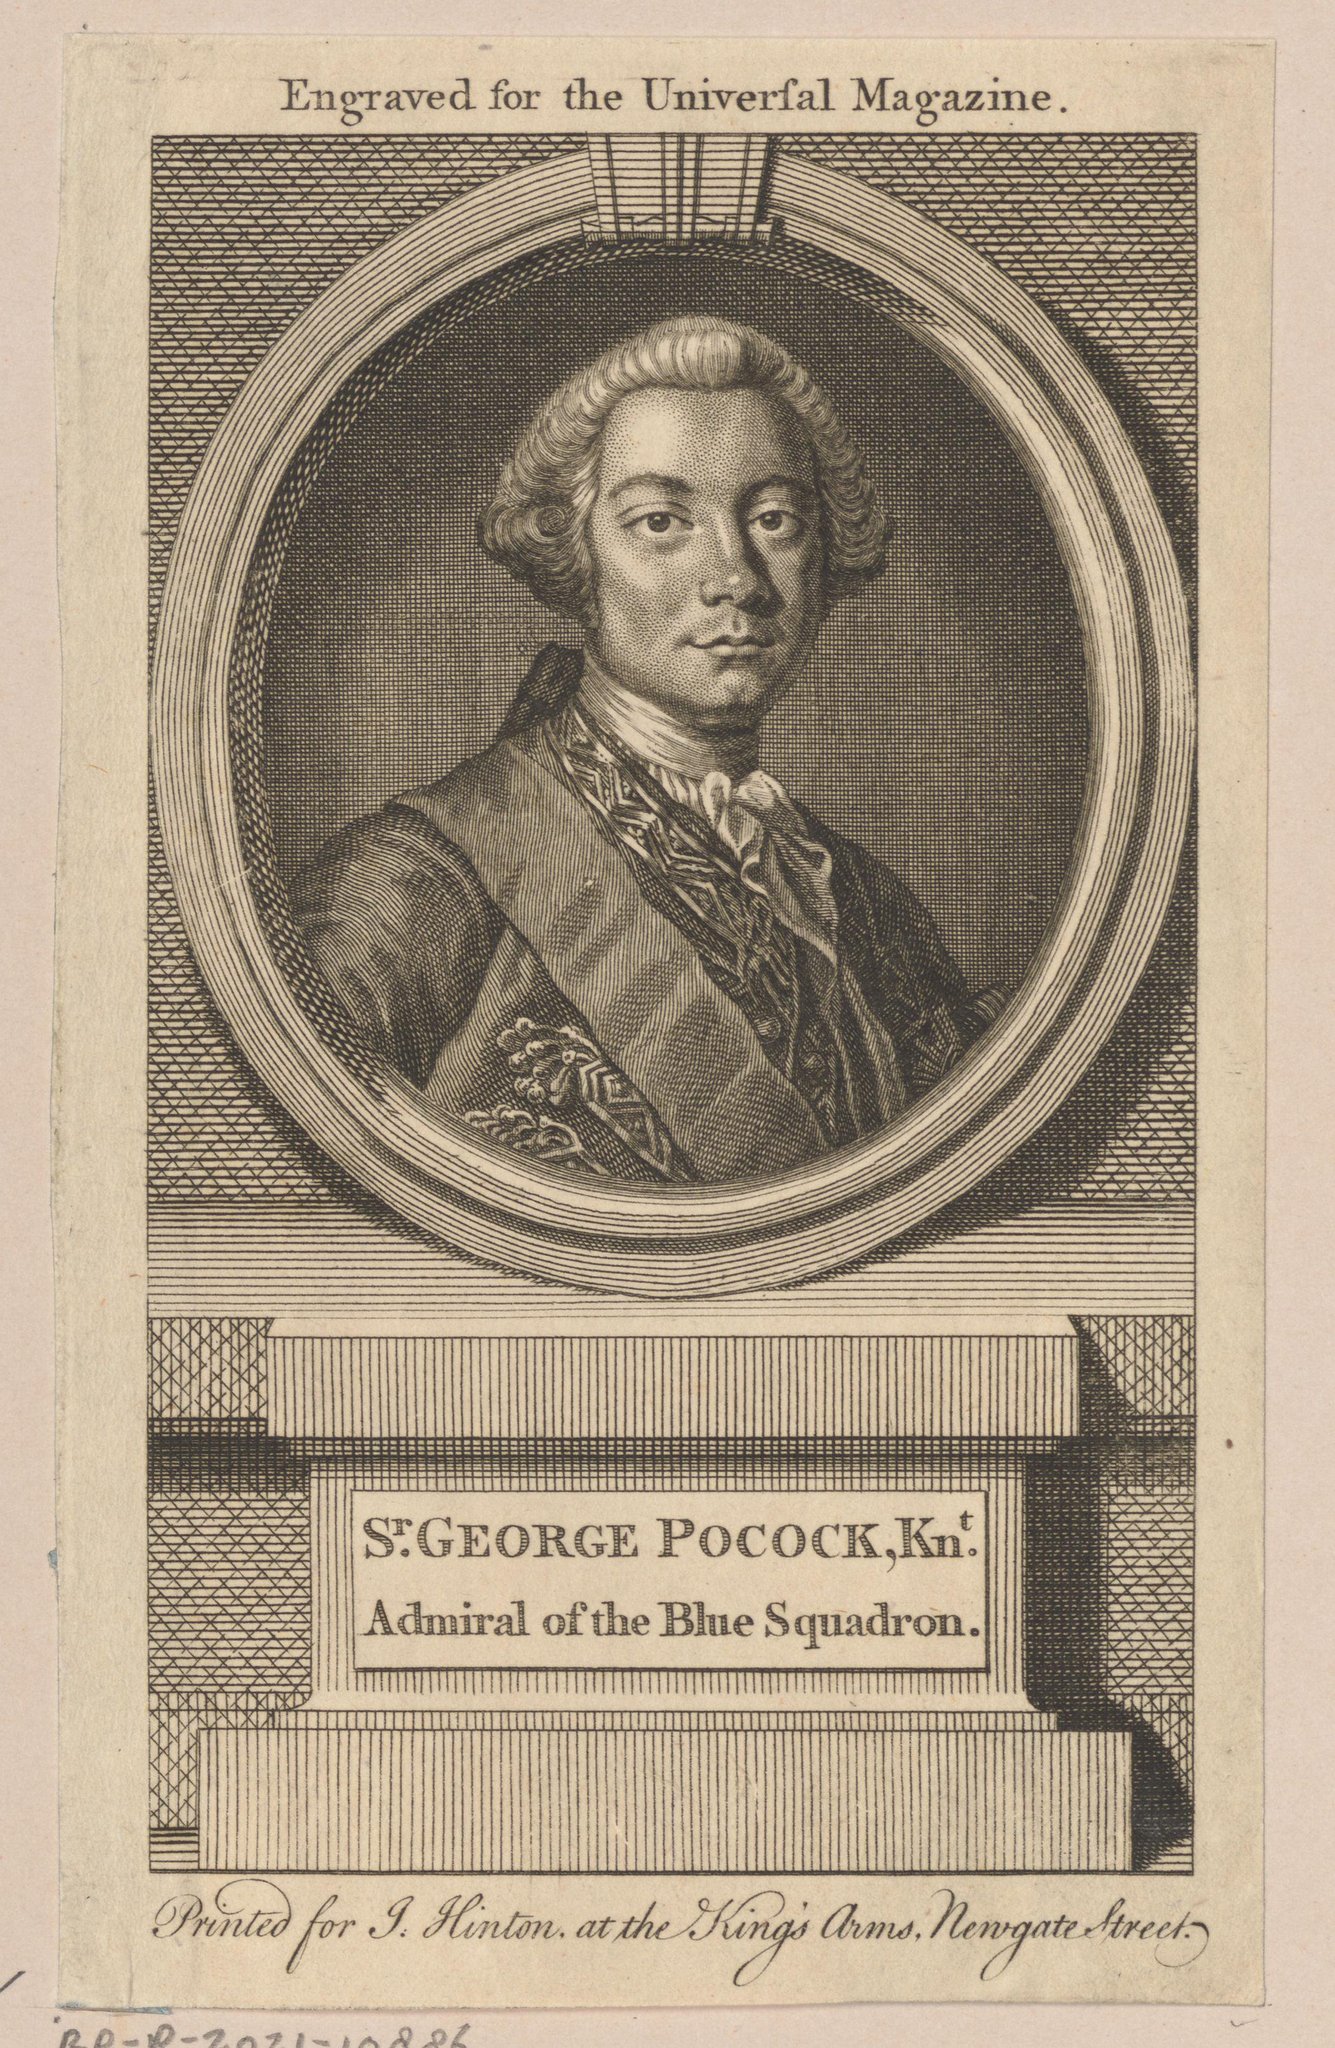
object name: print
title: Portret van George Pocock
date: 1747-1781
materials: paper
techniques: engraving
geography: london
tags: historical persons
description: De prent is waarschijnlijk gebruikt in een uitgave van de Universal Magazine.